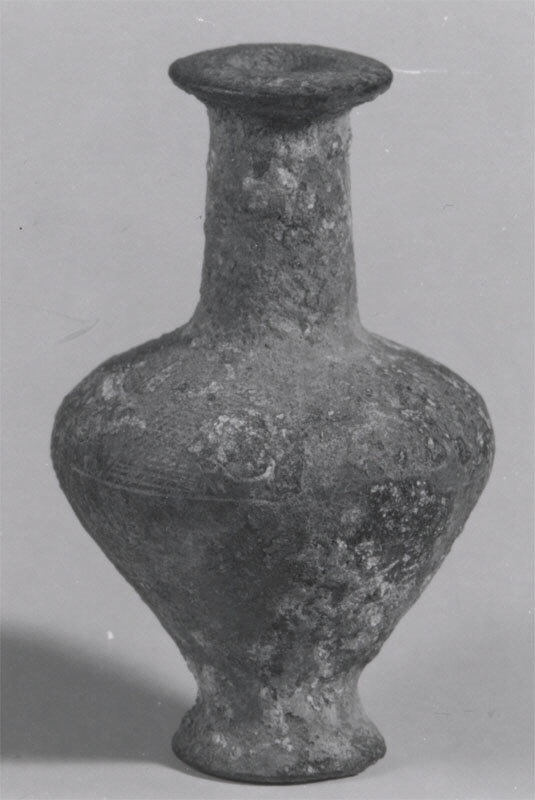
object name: cosmetic container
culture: bactria-margiana archaeological complex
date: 2333-1668 BCE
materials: copper alloy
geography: bactria-margiana